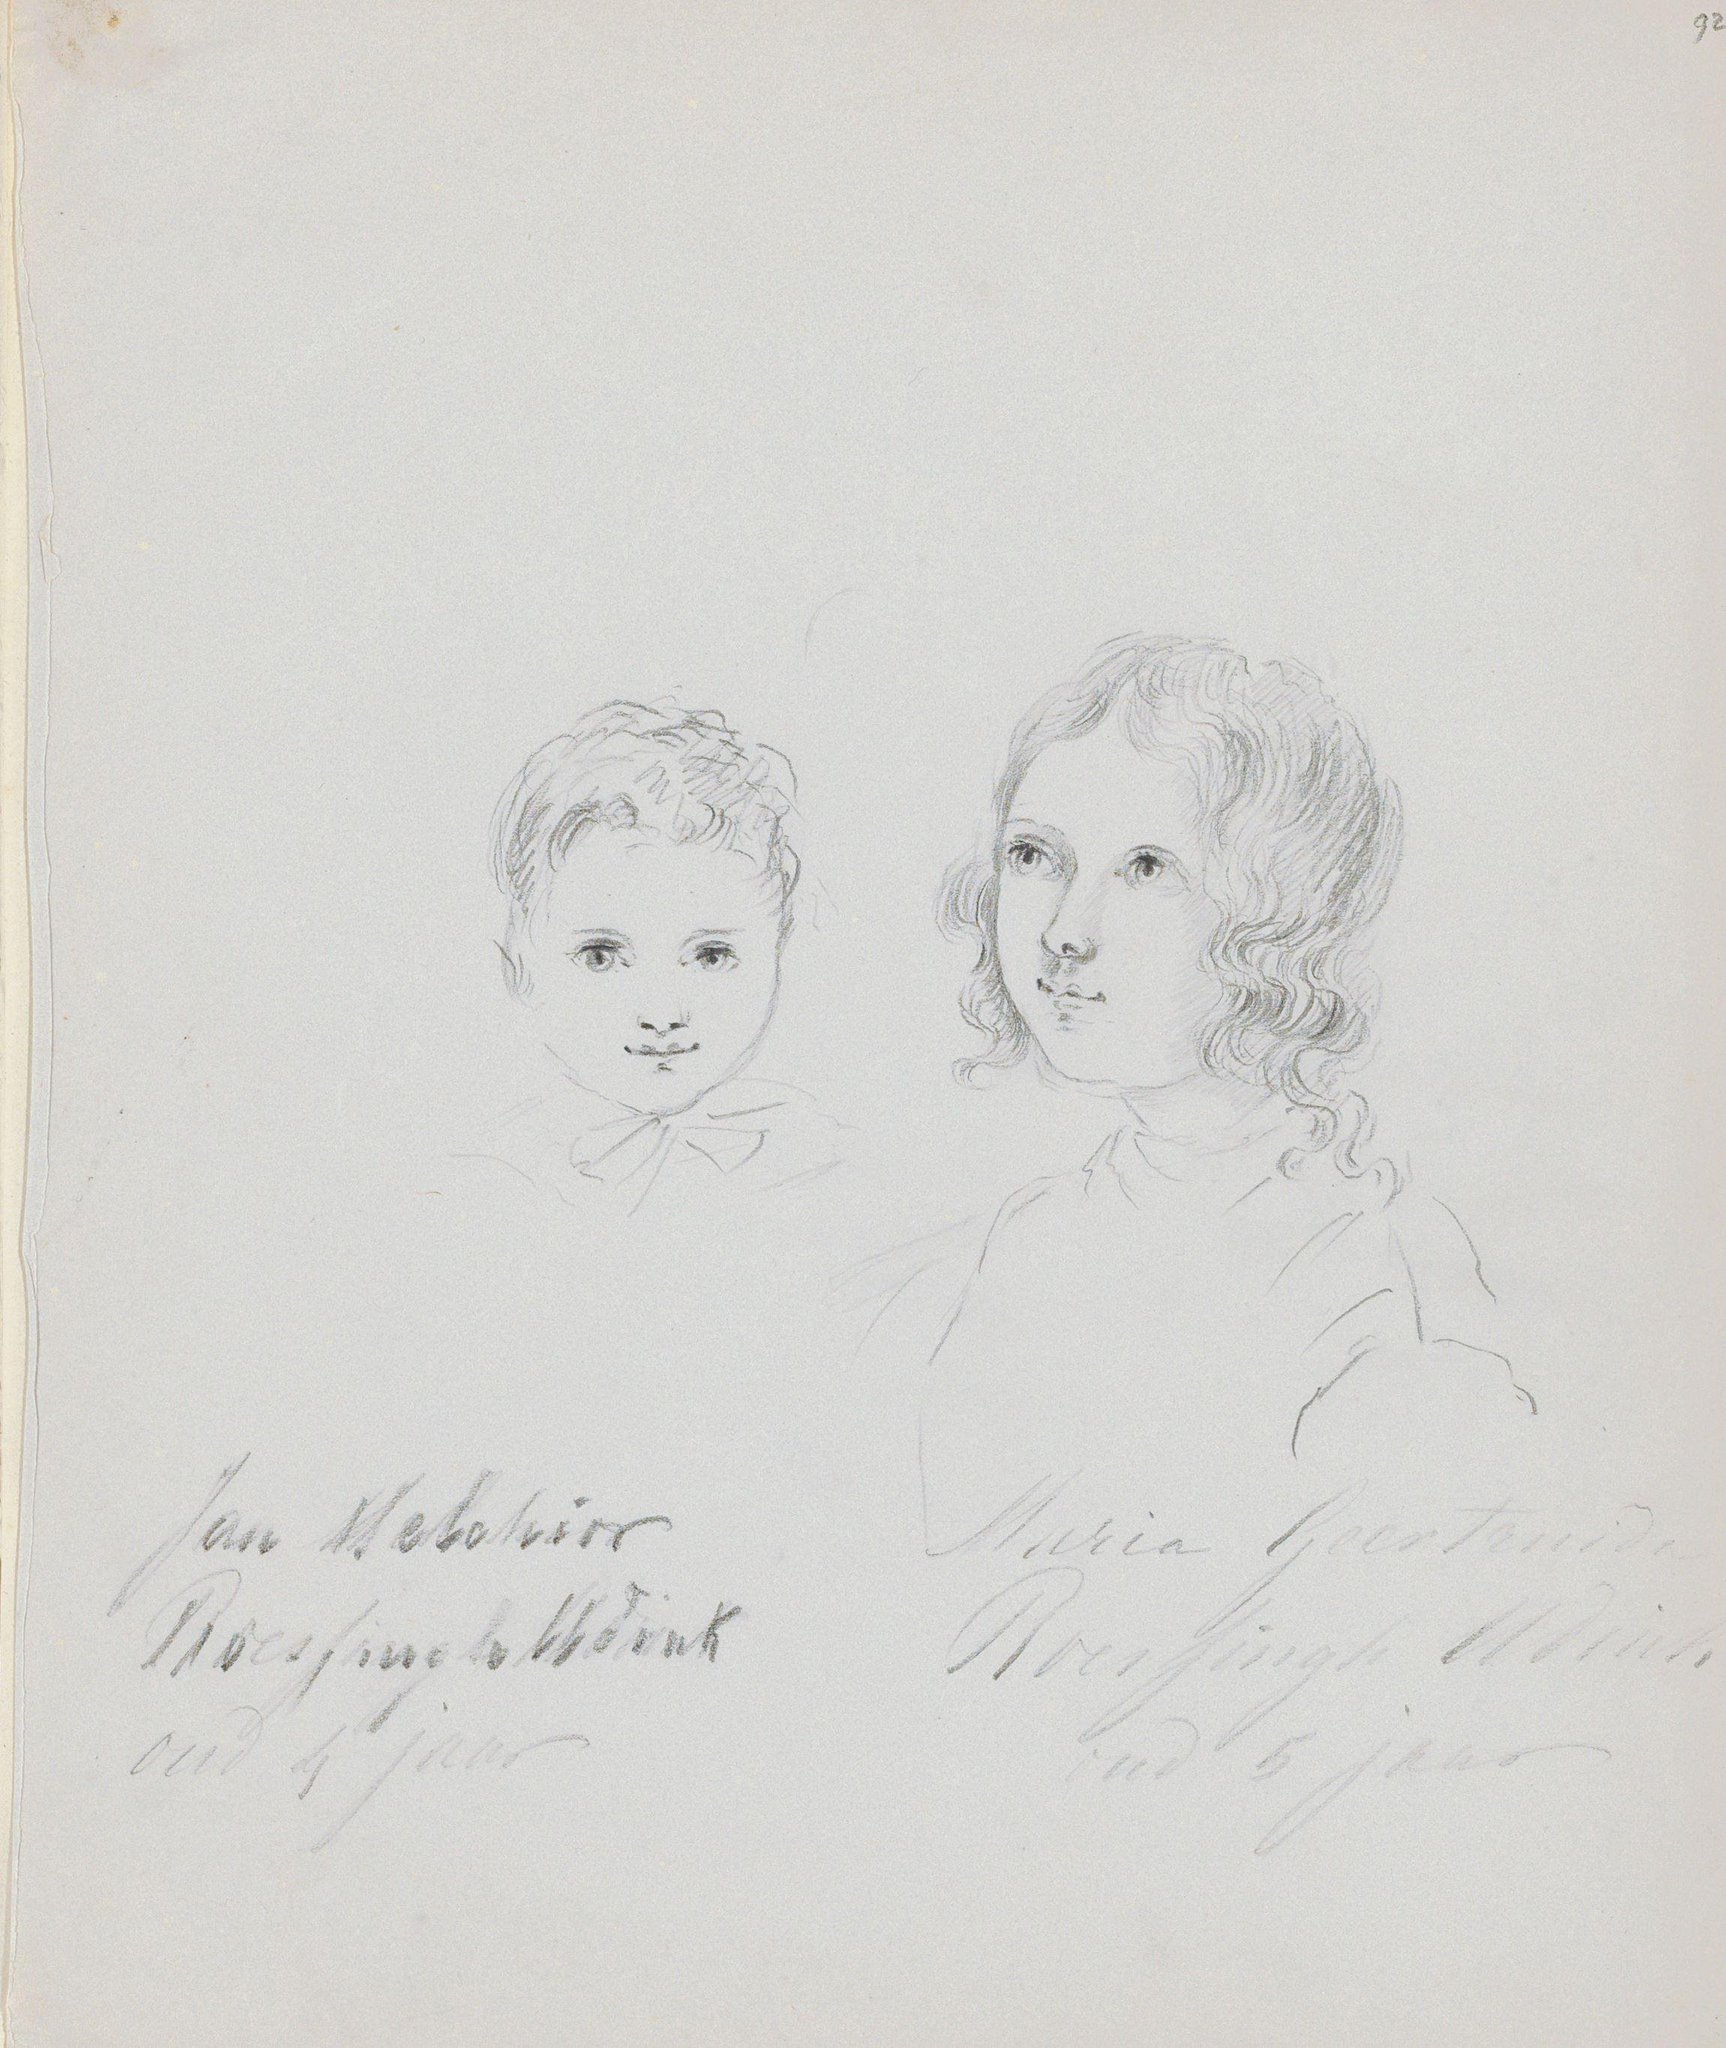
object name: sketchbook leaf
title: Portretten van Jan Melchior Roessingh Udink en Maria Geertruida Roessingh Udink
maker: jonkvrouw elisabeth kemper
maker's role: draughtsman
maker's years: 1799-1871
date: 1842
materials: paper, pencil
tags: boy (child between toddler and youth), girl (child between toddler and youth), historical persons (portraits and scenes from the life)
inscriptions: annotation: ‘Jan Melchior/ Roessingh Udink/ oud 4 jaar/ Maria Geertruida/ Roessingh Udink/ oud 5 jaar’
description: Losse tekening ingeplakt op blad 92 recto uit een schetsboek met 94 bladen.